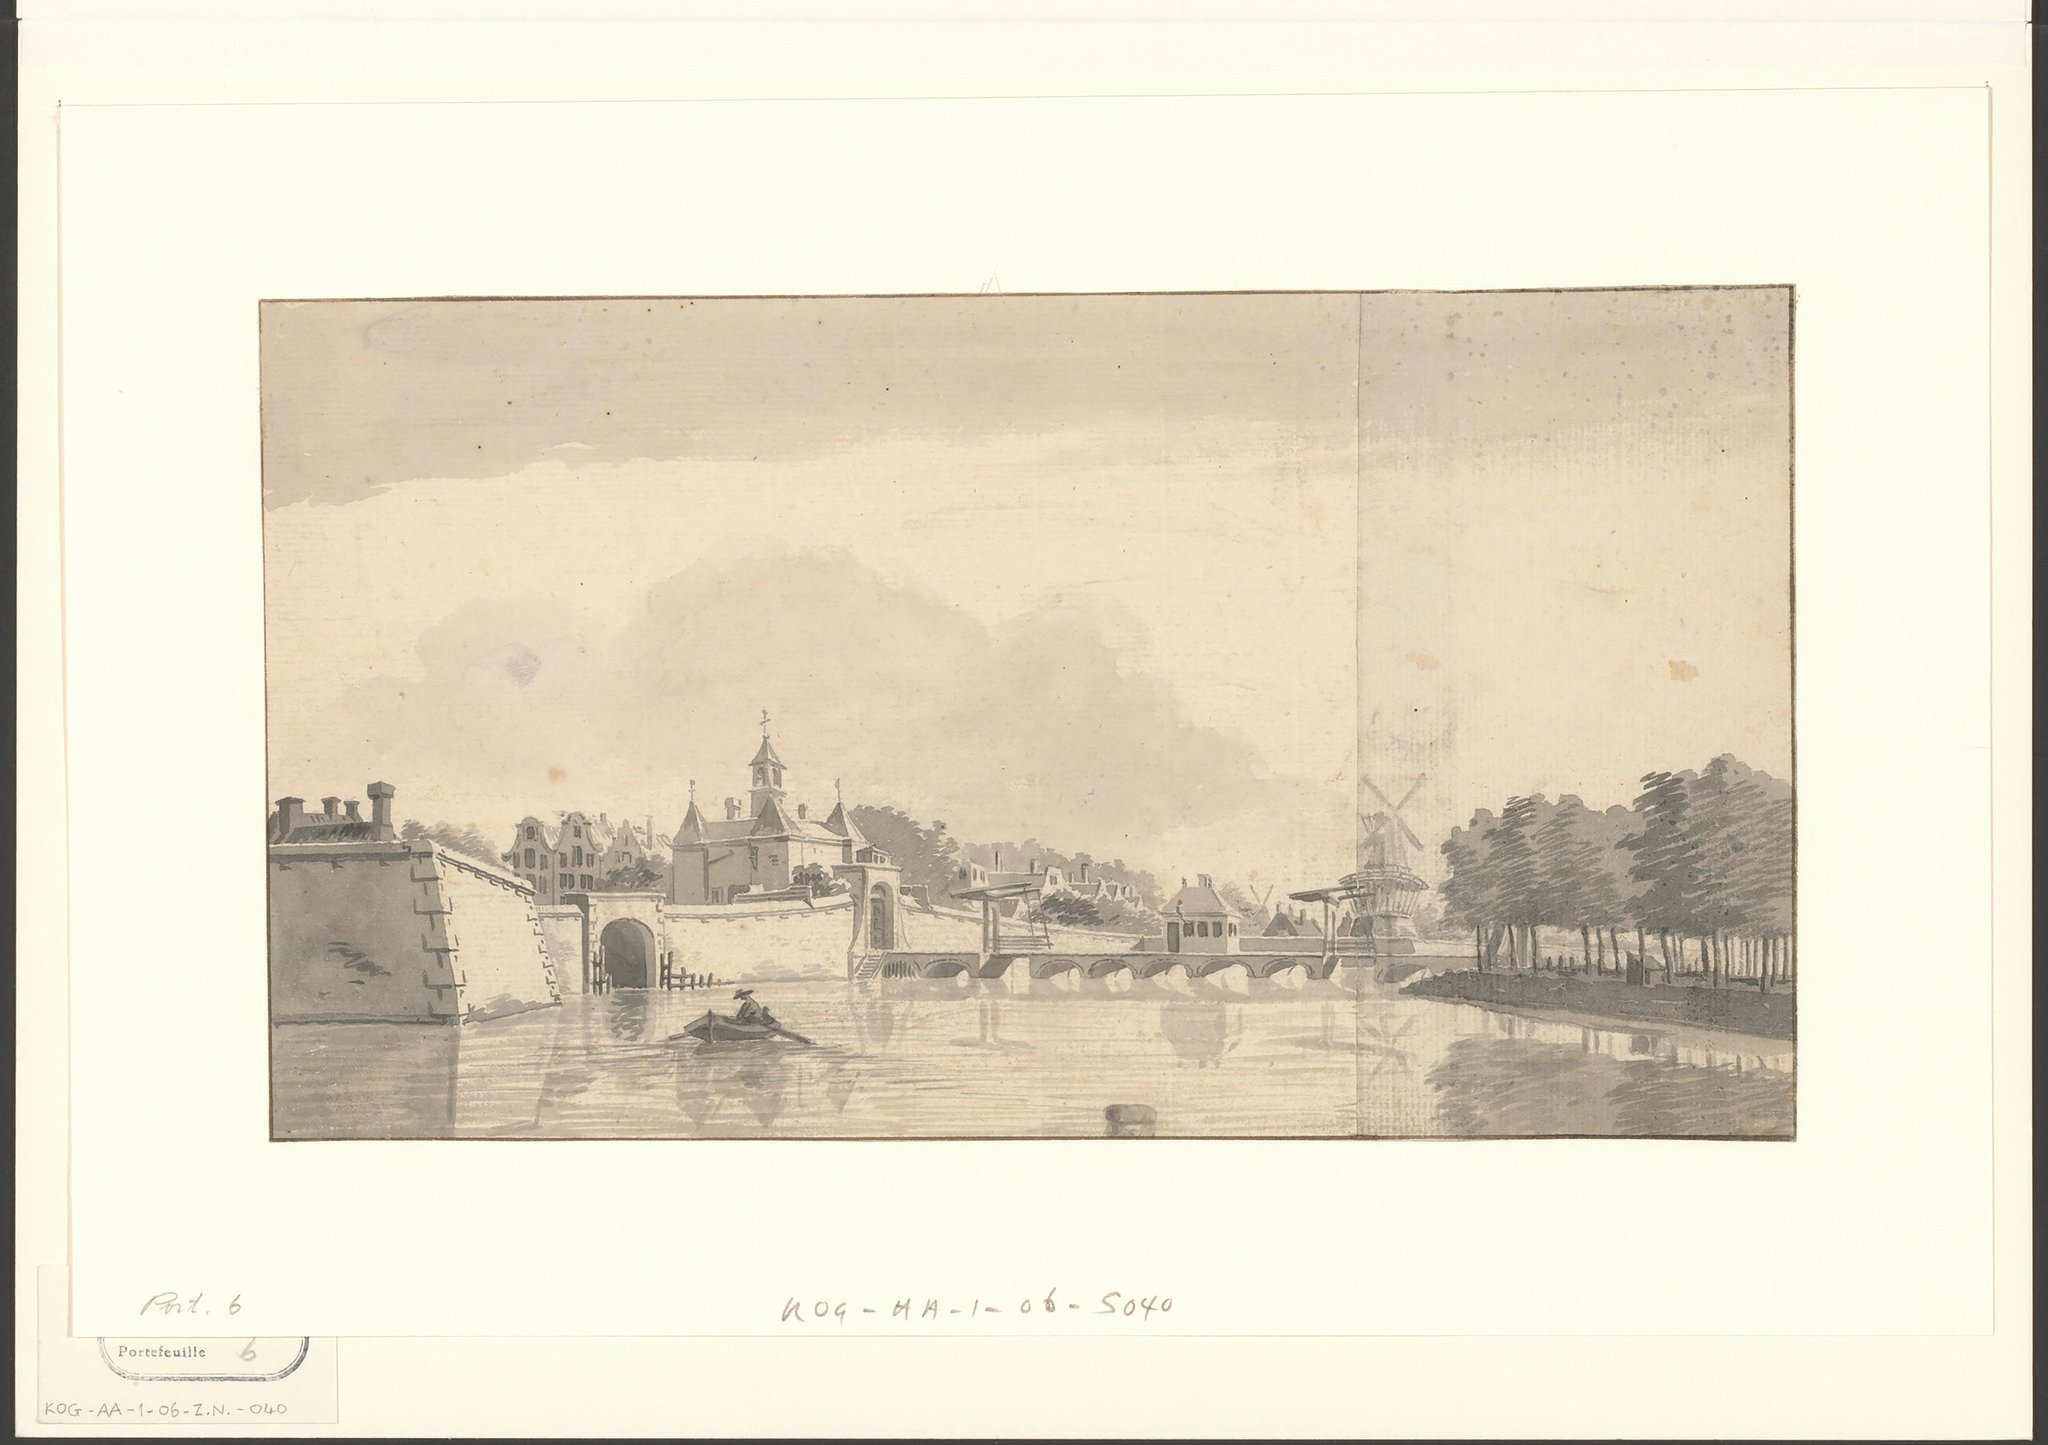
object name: drawing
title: Gezicht op een vestingwal bij de Leidsepoort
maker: dirk verrijk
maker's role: draughtsman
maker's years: 1734-1786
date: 1777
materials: ink, paper, pencil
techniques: brush, pen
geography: amsterdam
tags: city-view in general; 'veduta', river, windmill in landscape, bridge in city across river, canal, etc., city-gate, boat propelled by man or animal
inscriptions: inscription: ‘Port. 6’, inscription: ‘de Leydepoort / Geschenk / van den Heer Bak / huizen [...] Hoge / Lytsche poort / gedaen IIII’, collector's mark: ‘6’ Lugt 1641b, date: ‘by [...] 24 July 1777’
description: Onderwerpsrubriek binnen de Atlas Amsterdam: Buitensingel, Gezichten langs en op de Stadsvest van Haarlemmerpoort tot Raampoort.